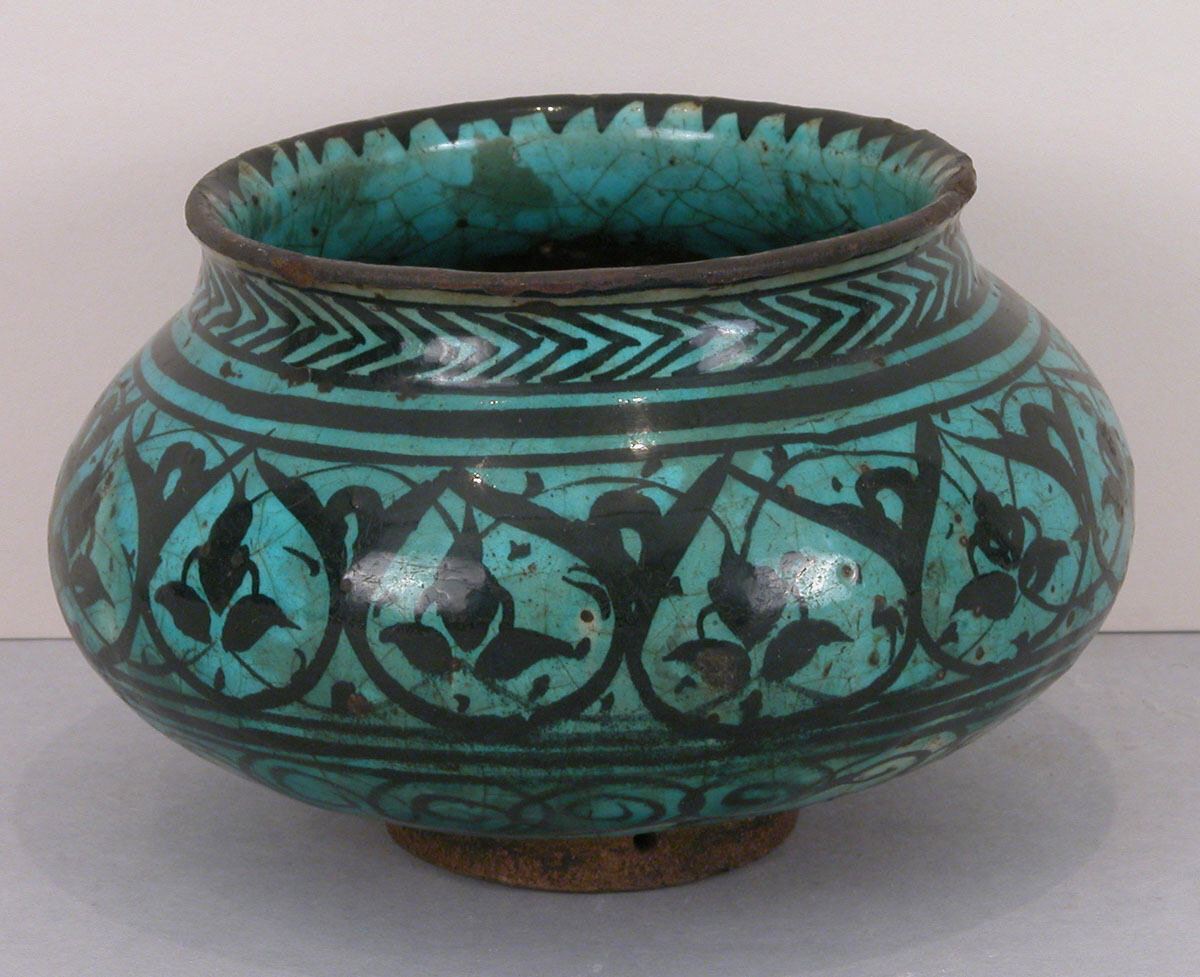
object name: bowl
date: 1201-1400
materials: stonepaste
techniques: painting, underglaze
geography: syria